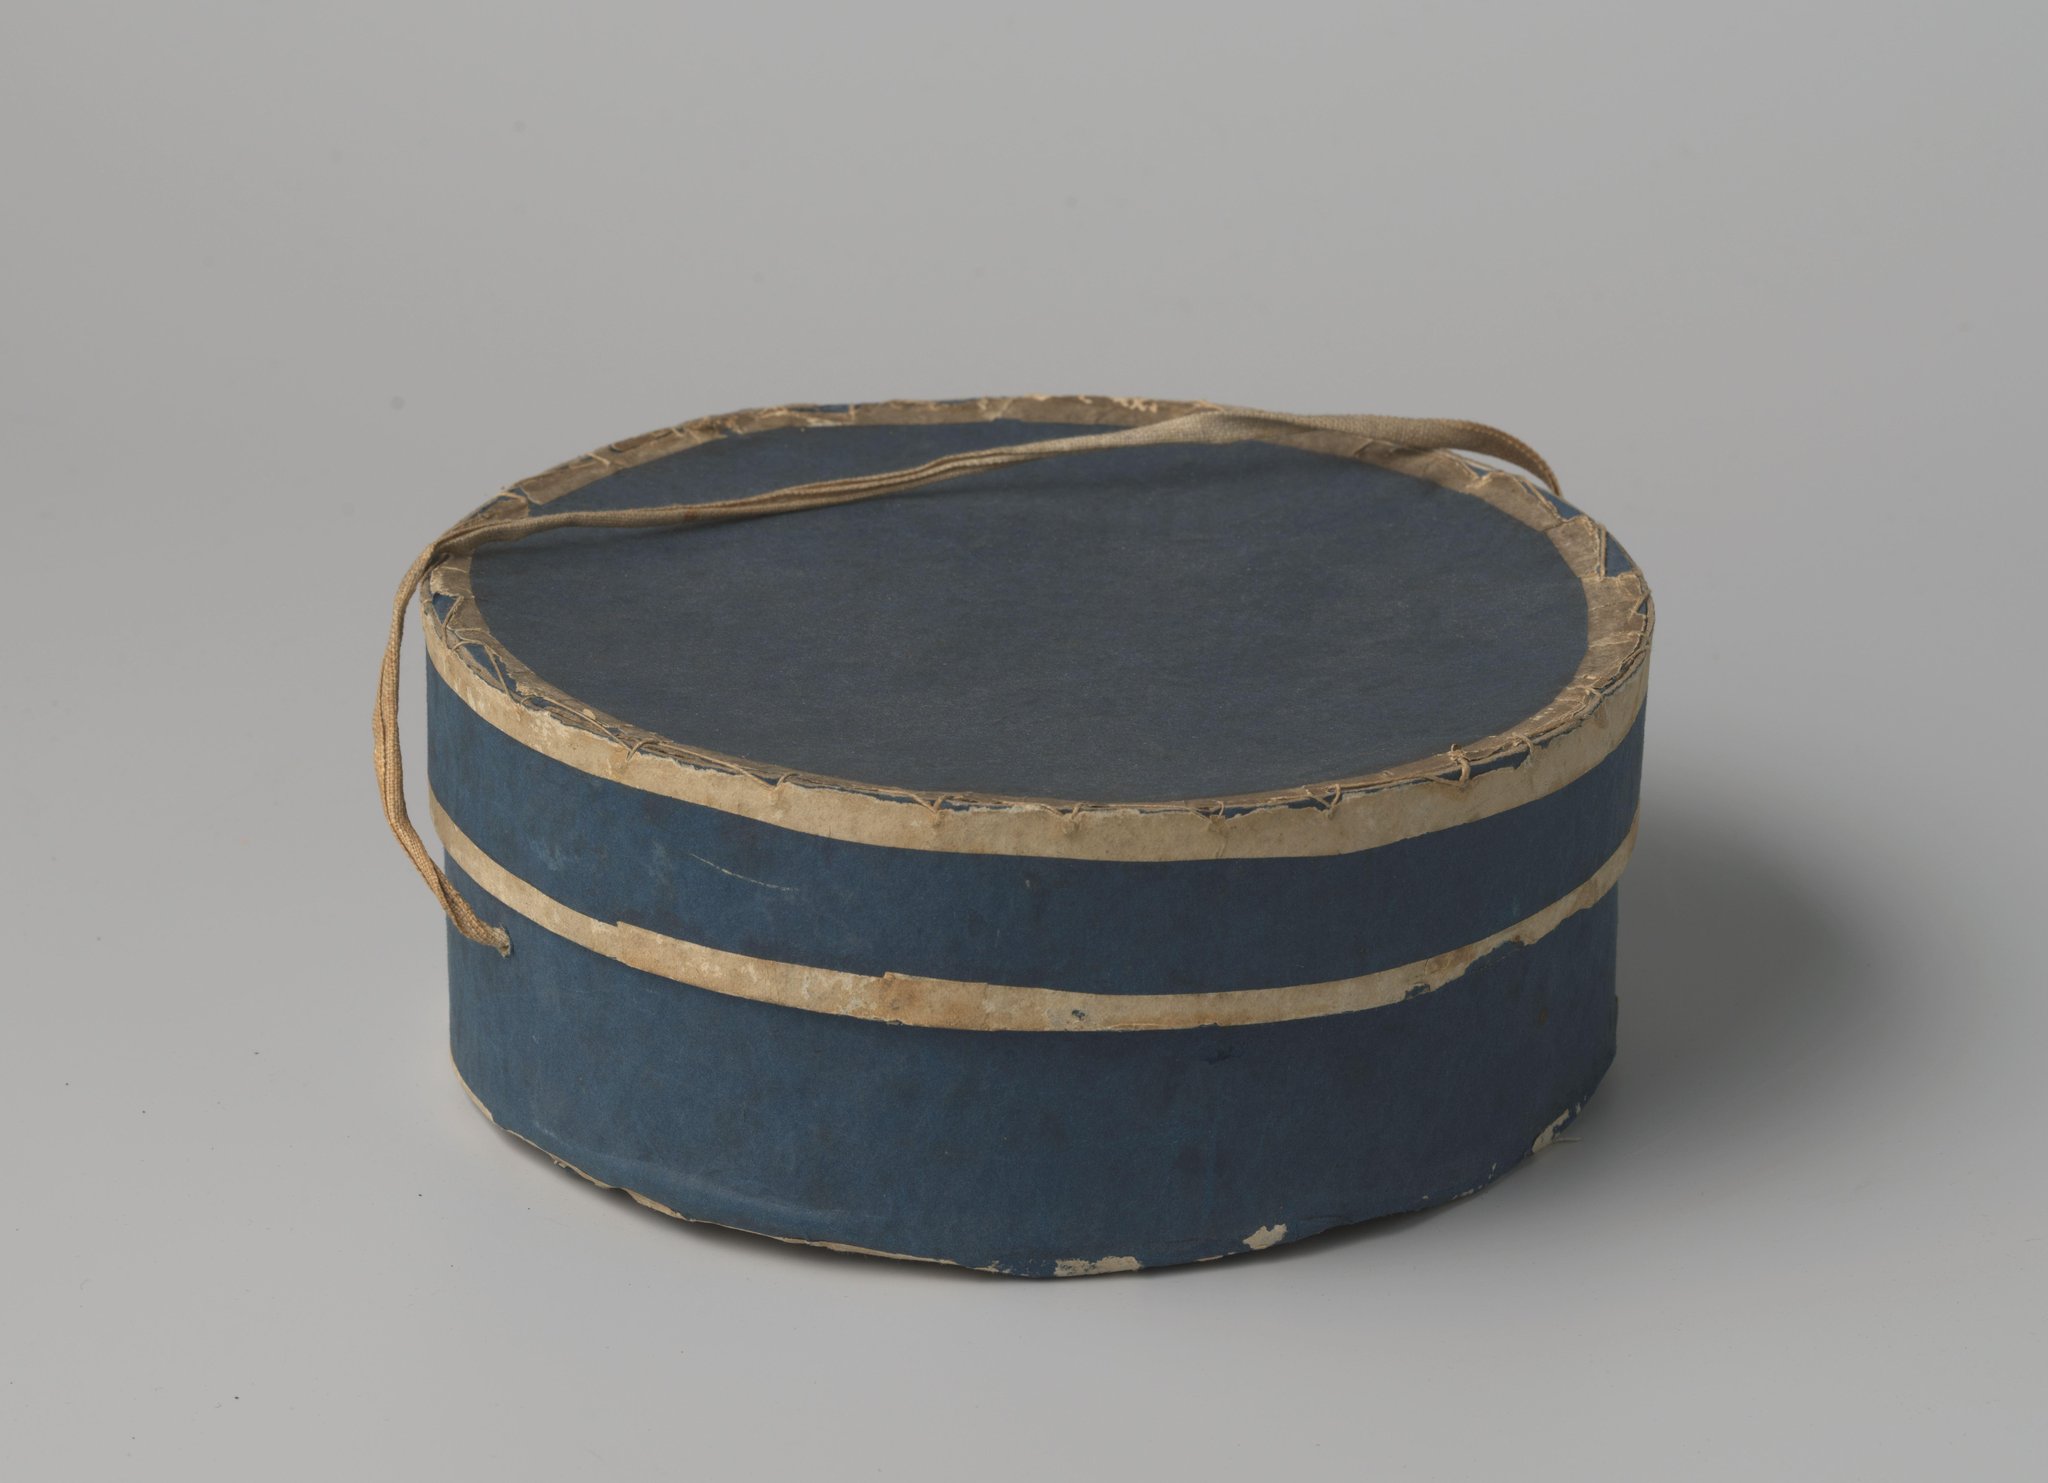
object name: hat box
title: Ronde hoedendoos van karton, beplakt met donkerblauw papier met witte biezen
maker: Anonymous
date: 1925-1950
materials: cardboard, linen, paper, fiber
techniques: sewing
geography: western europe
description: Ronde hoedendoos van karton, beplakt met donkerblauw papier met witte biezen.